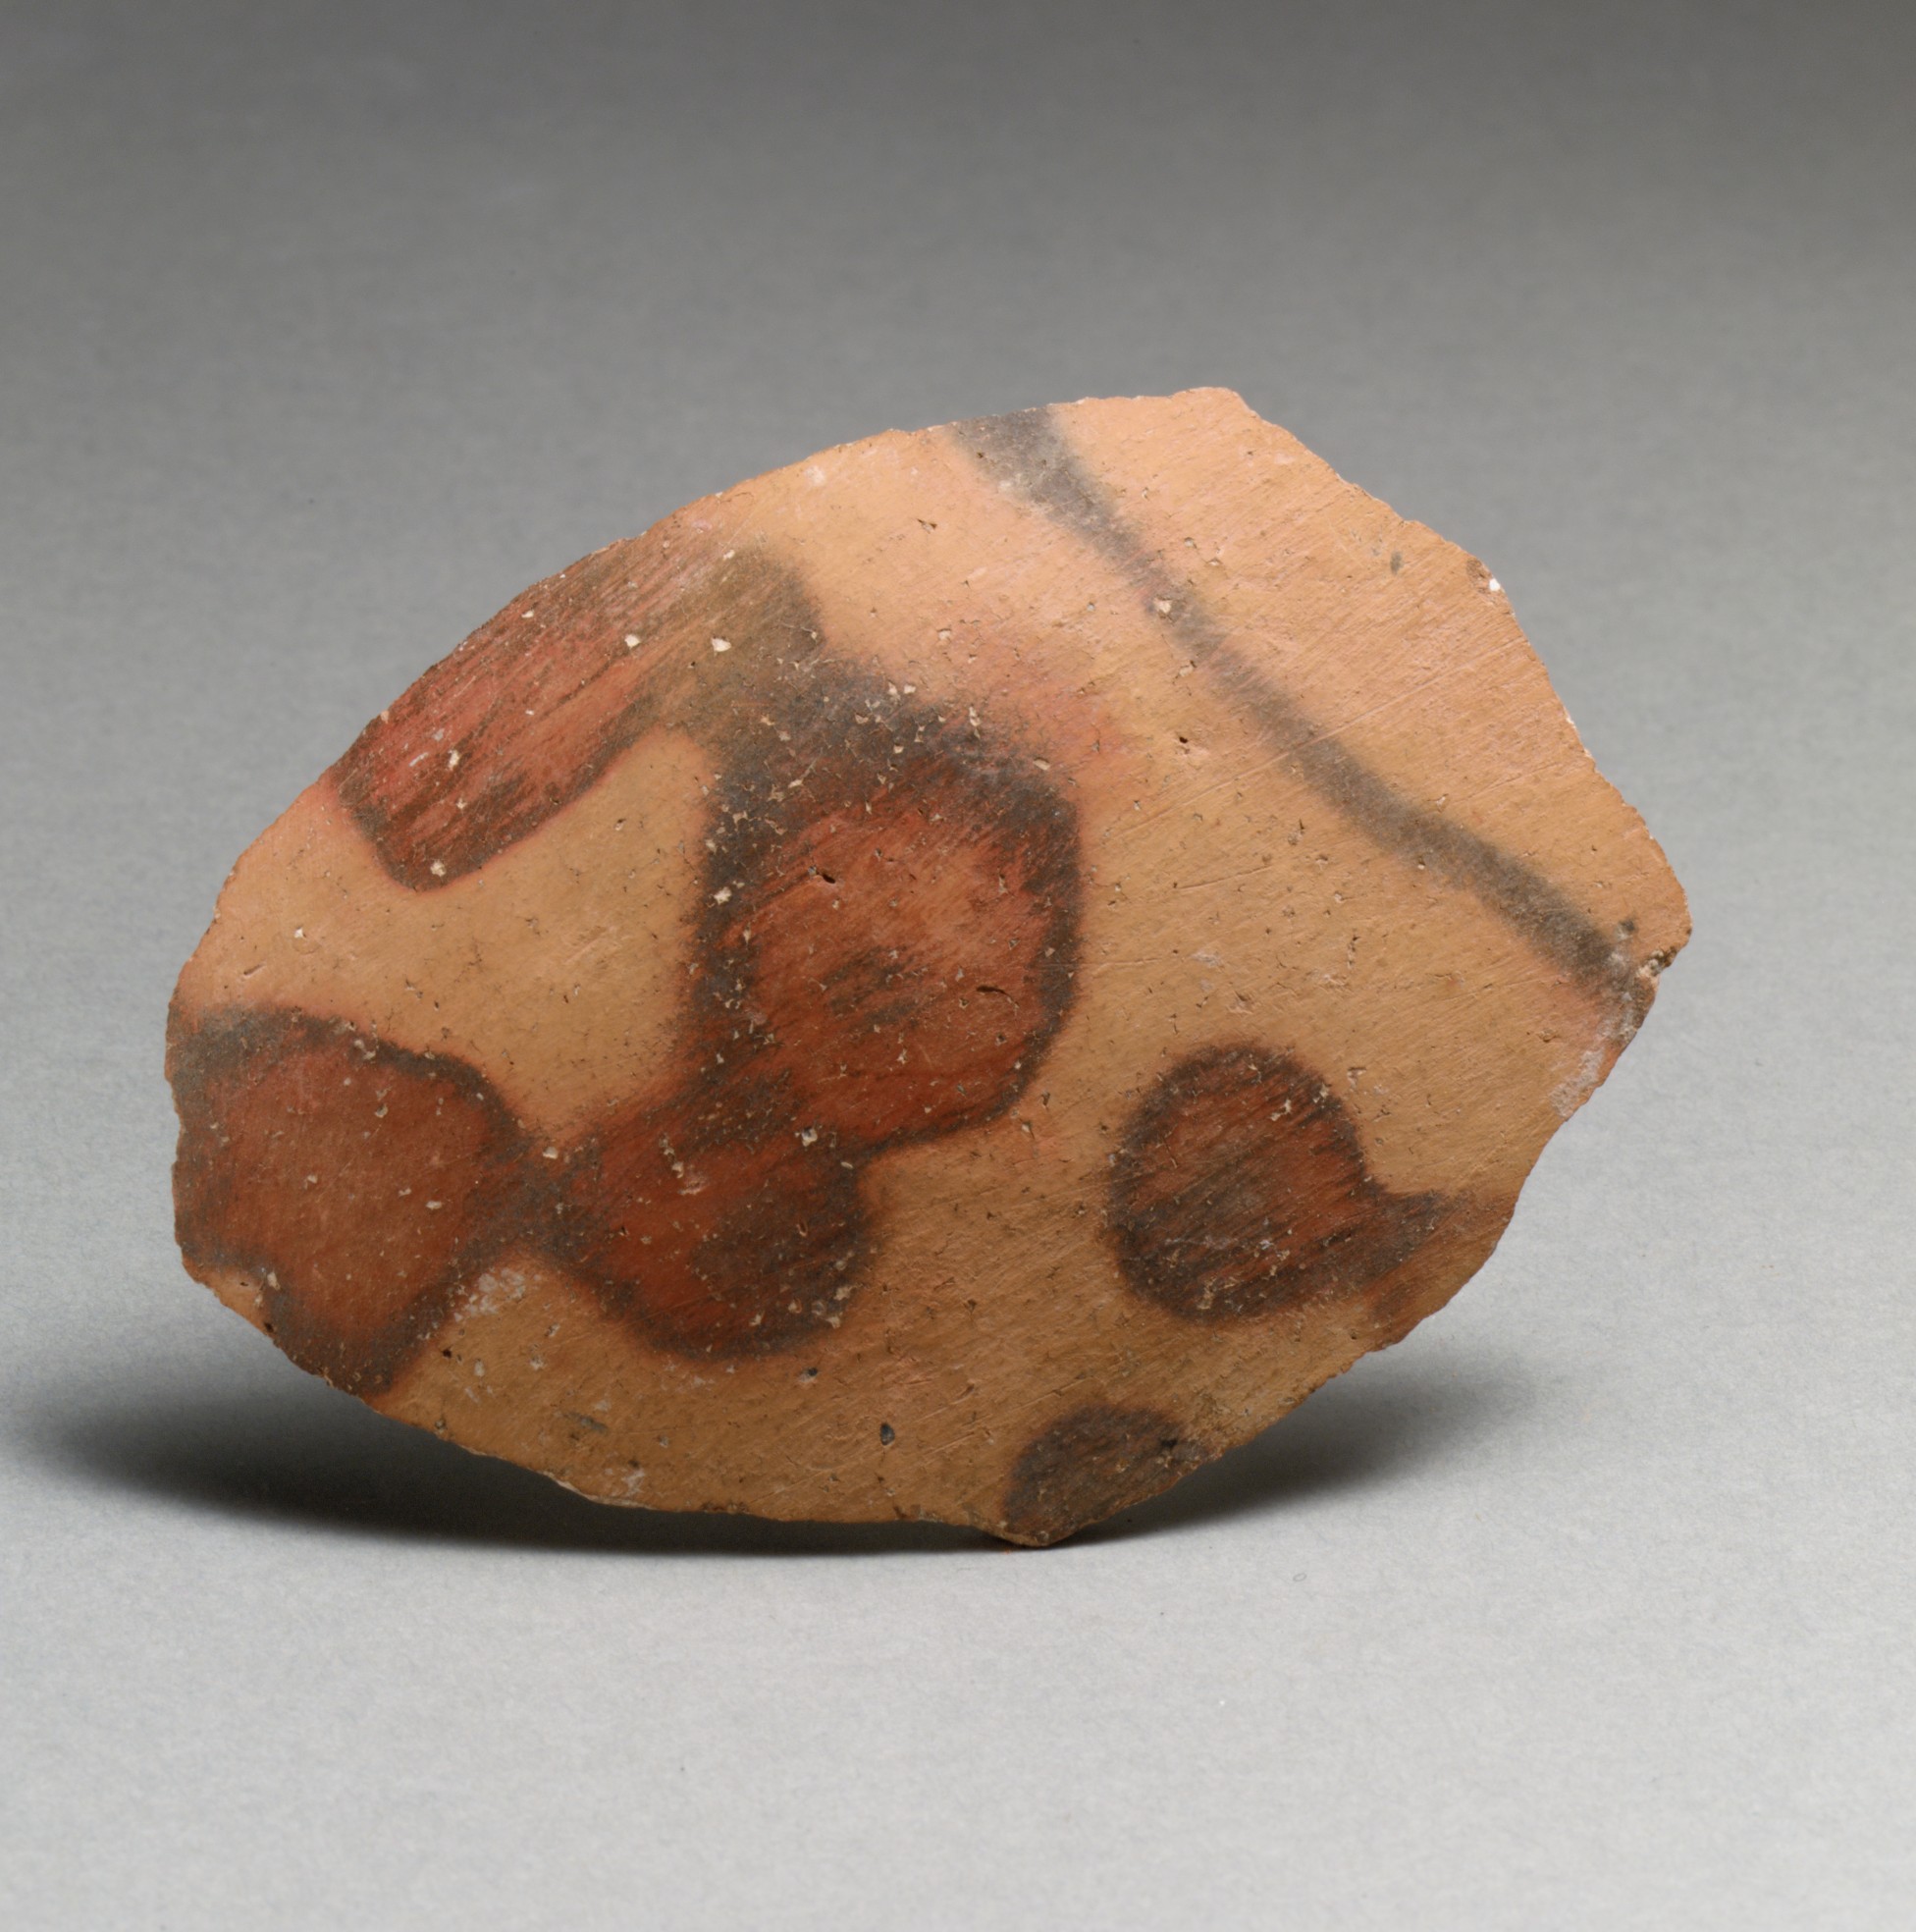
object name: vase fragment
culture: minoan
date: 2600-2000 BCE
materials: terracotta